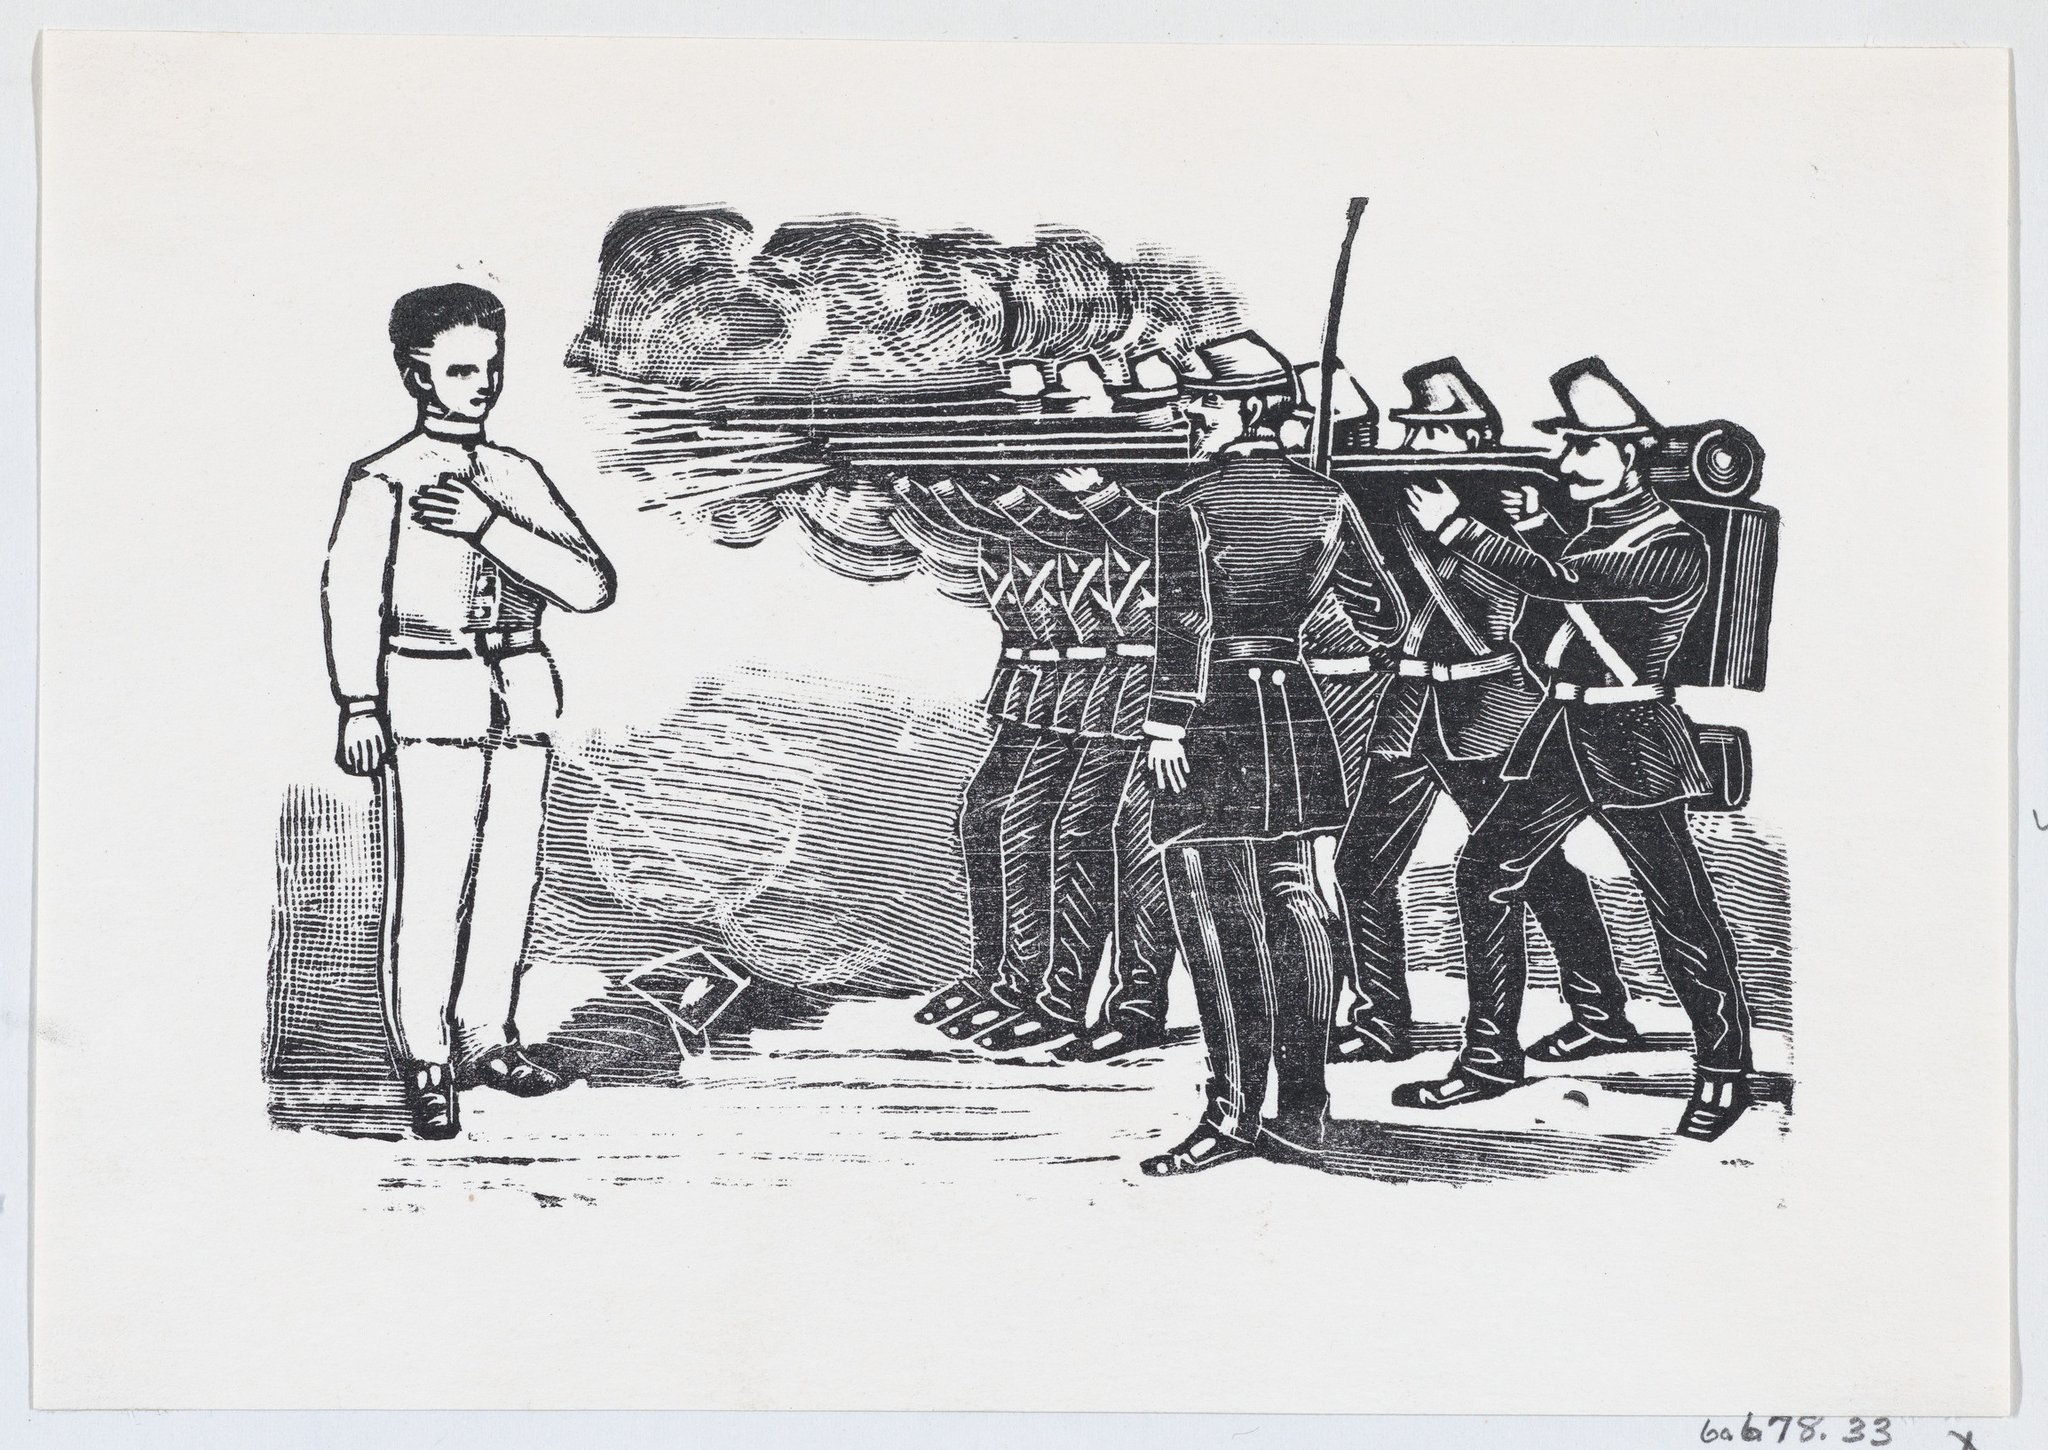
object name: print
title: Firing squad shooting a man with his left hand on his chest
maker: josé guadalupe posada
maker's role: artist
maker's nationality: mexican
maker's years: 1852-1913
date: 1880-1910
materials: metal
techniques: engraving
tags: military,firearms,men,execution